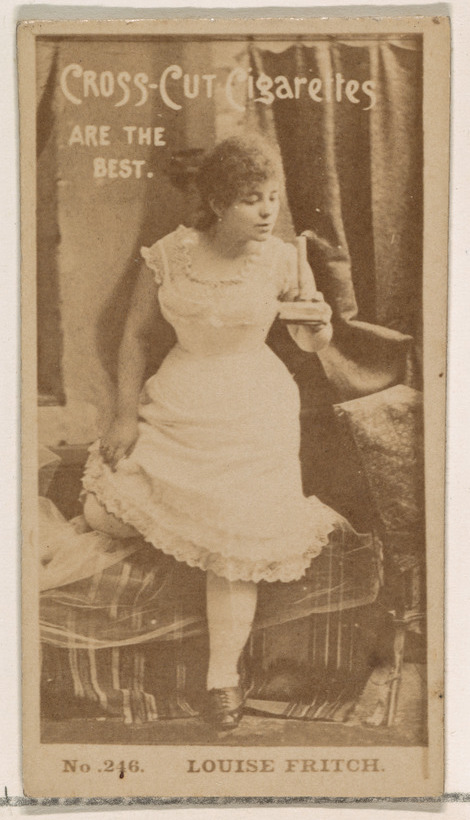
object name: print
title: Card Number 246, Louise Fritch, from the Actors and Actresses series (N145-2) issued by Duke Sons & Co. to promote Cross Cut Cigarettes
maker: w. duke, sons & co.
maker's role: publisher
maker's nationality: american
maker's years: 1870-1920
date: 1880-1889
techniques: albumen silver print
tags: portraits,women,actresses